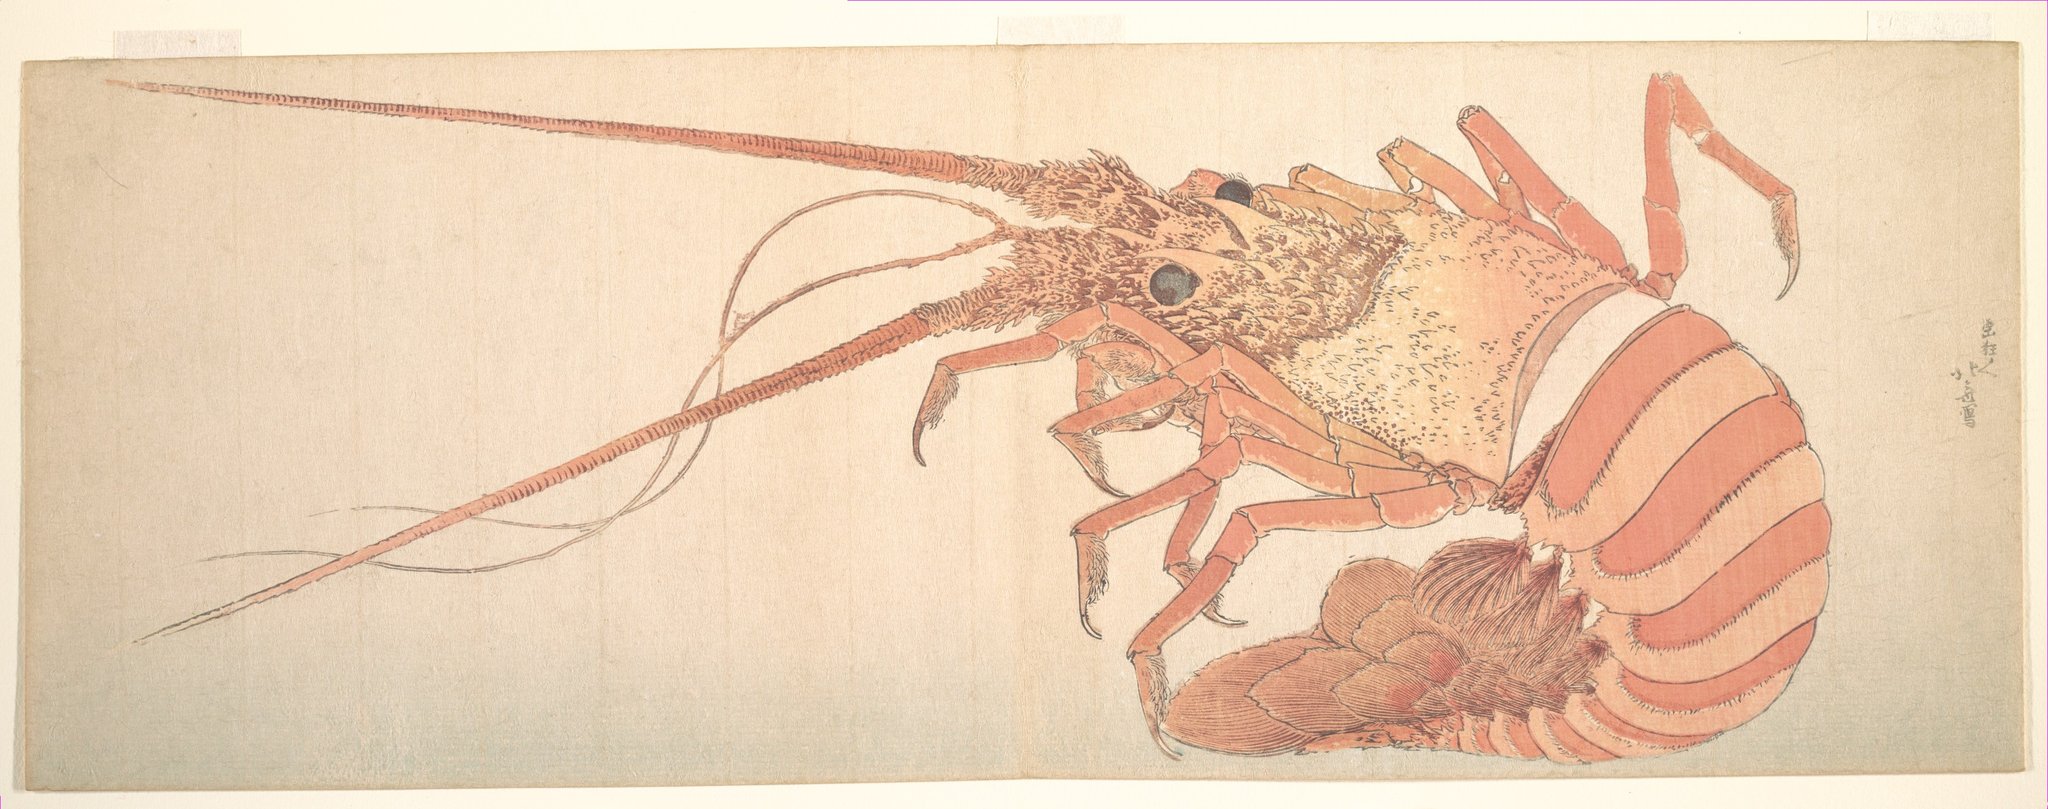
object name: print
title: Large Lobster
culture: japanese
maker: katsushika hokusai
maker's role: artist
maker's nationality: japanese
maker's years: 1760-1849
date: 1800-1815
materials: ink, paper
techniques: surimono, woodblock print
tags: lobsters